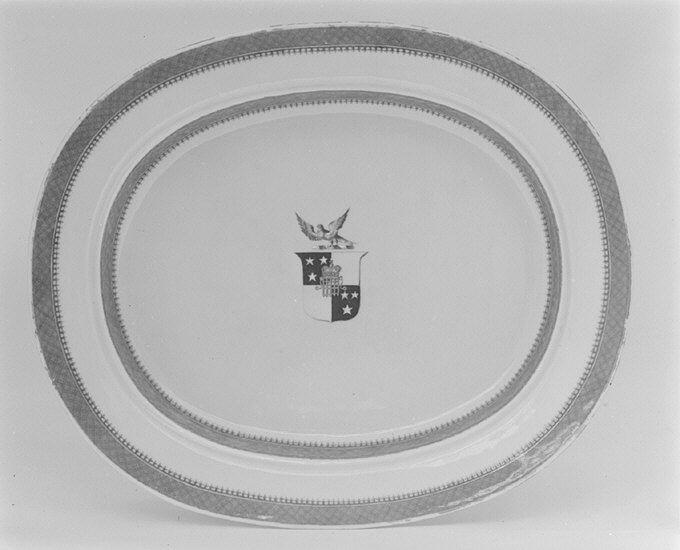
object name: platter and rack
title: Platter with rack (part of a service)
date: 1790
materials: hard paste porcelain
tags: birds,coat of arms